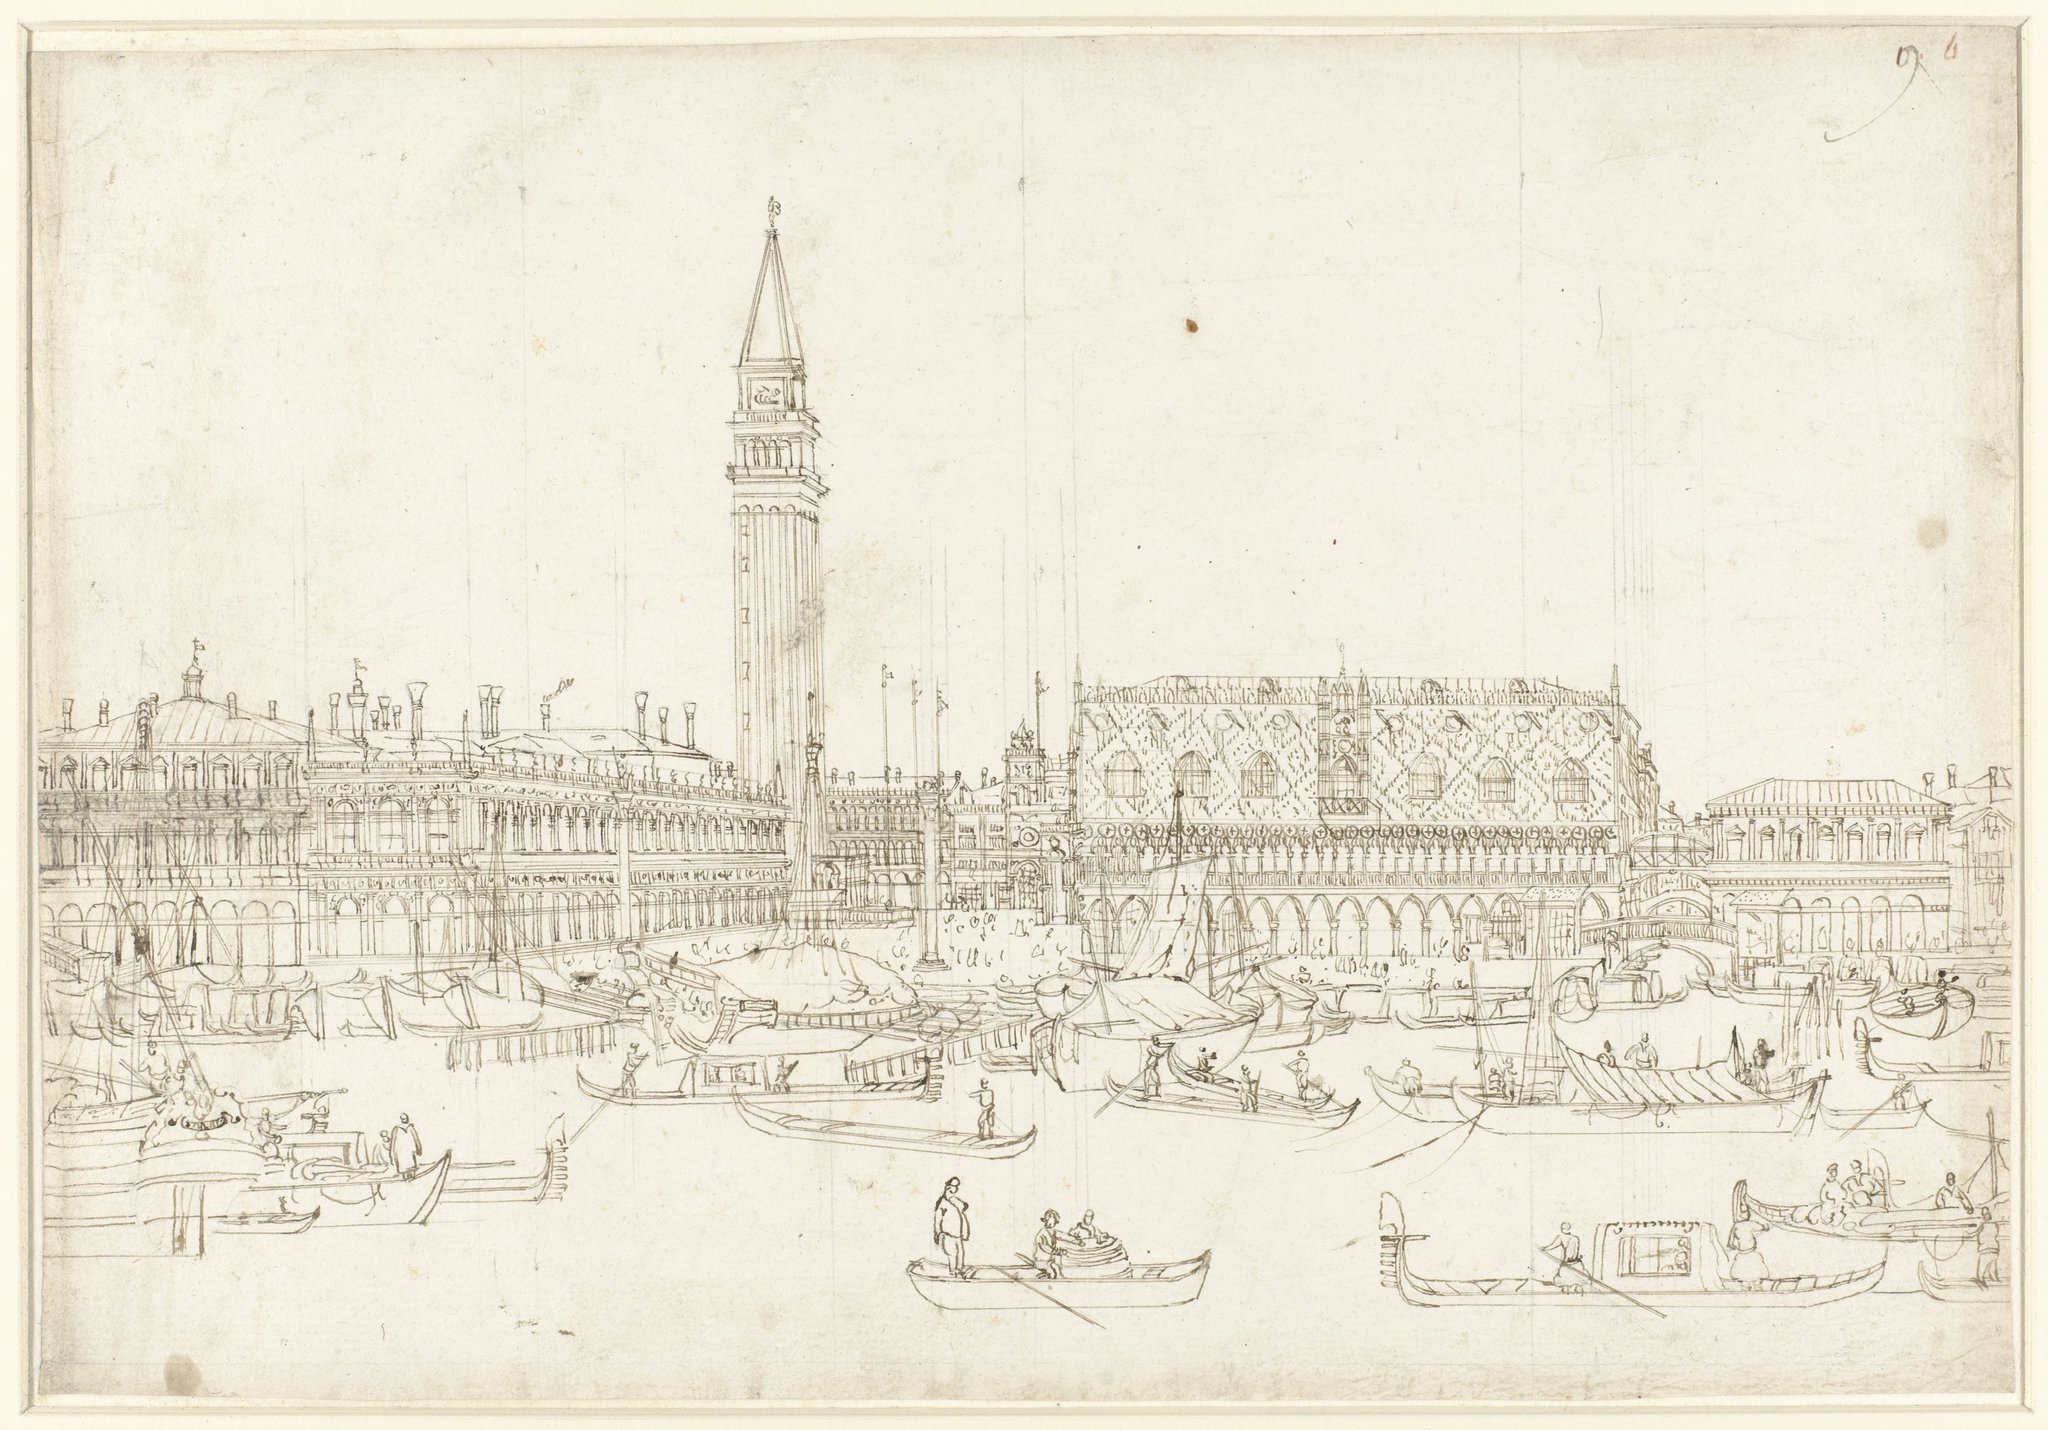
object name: drawing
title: Gezicht op de Bibliotheek, Campanile en Dogenpaleis te Venetië, gezien vanaf het water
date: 1730-1780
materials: ink, paper, pencil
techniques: pen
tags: square, place, circus, etc., public road, italy, venice